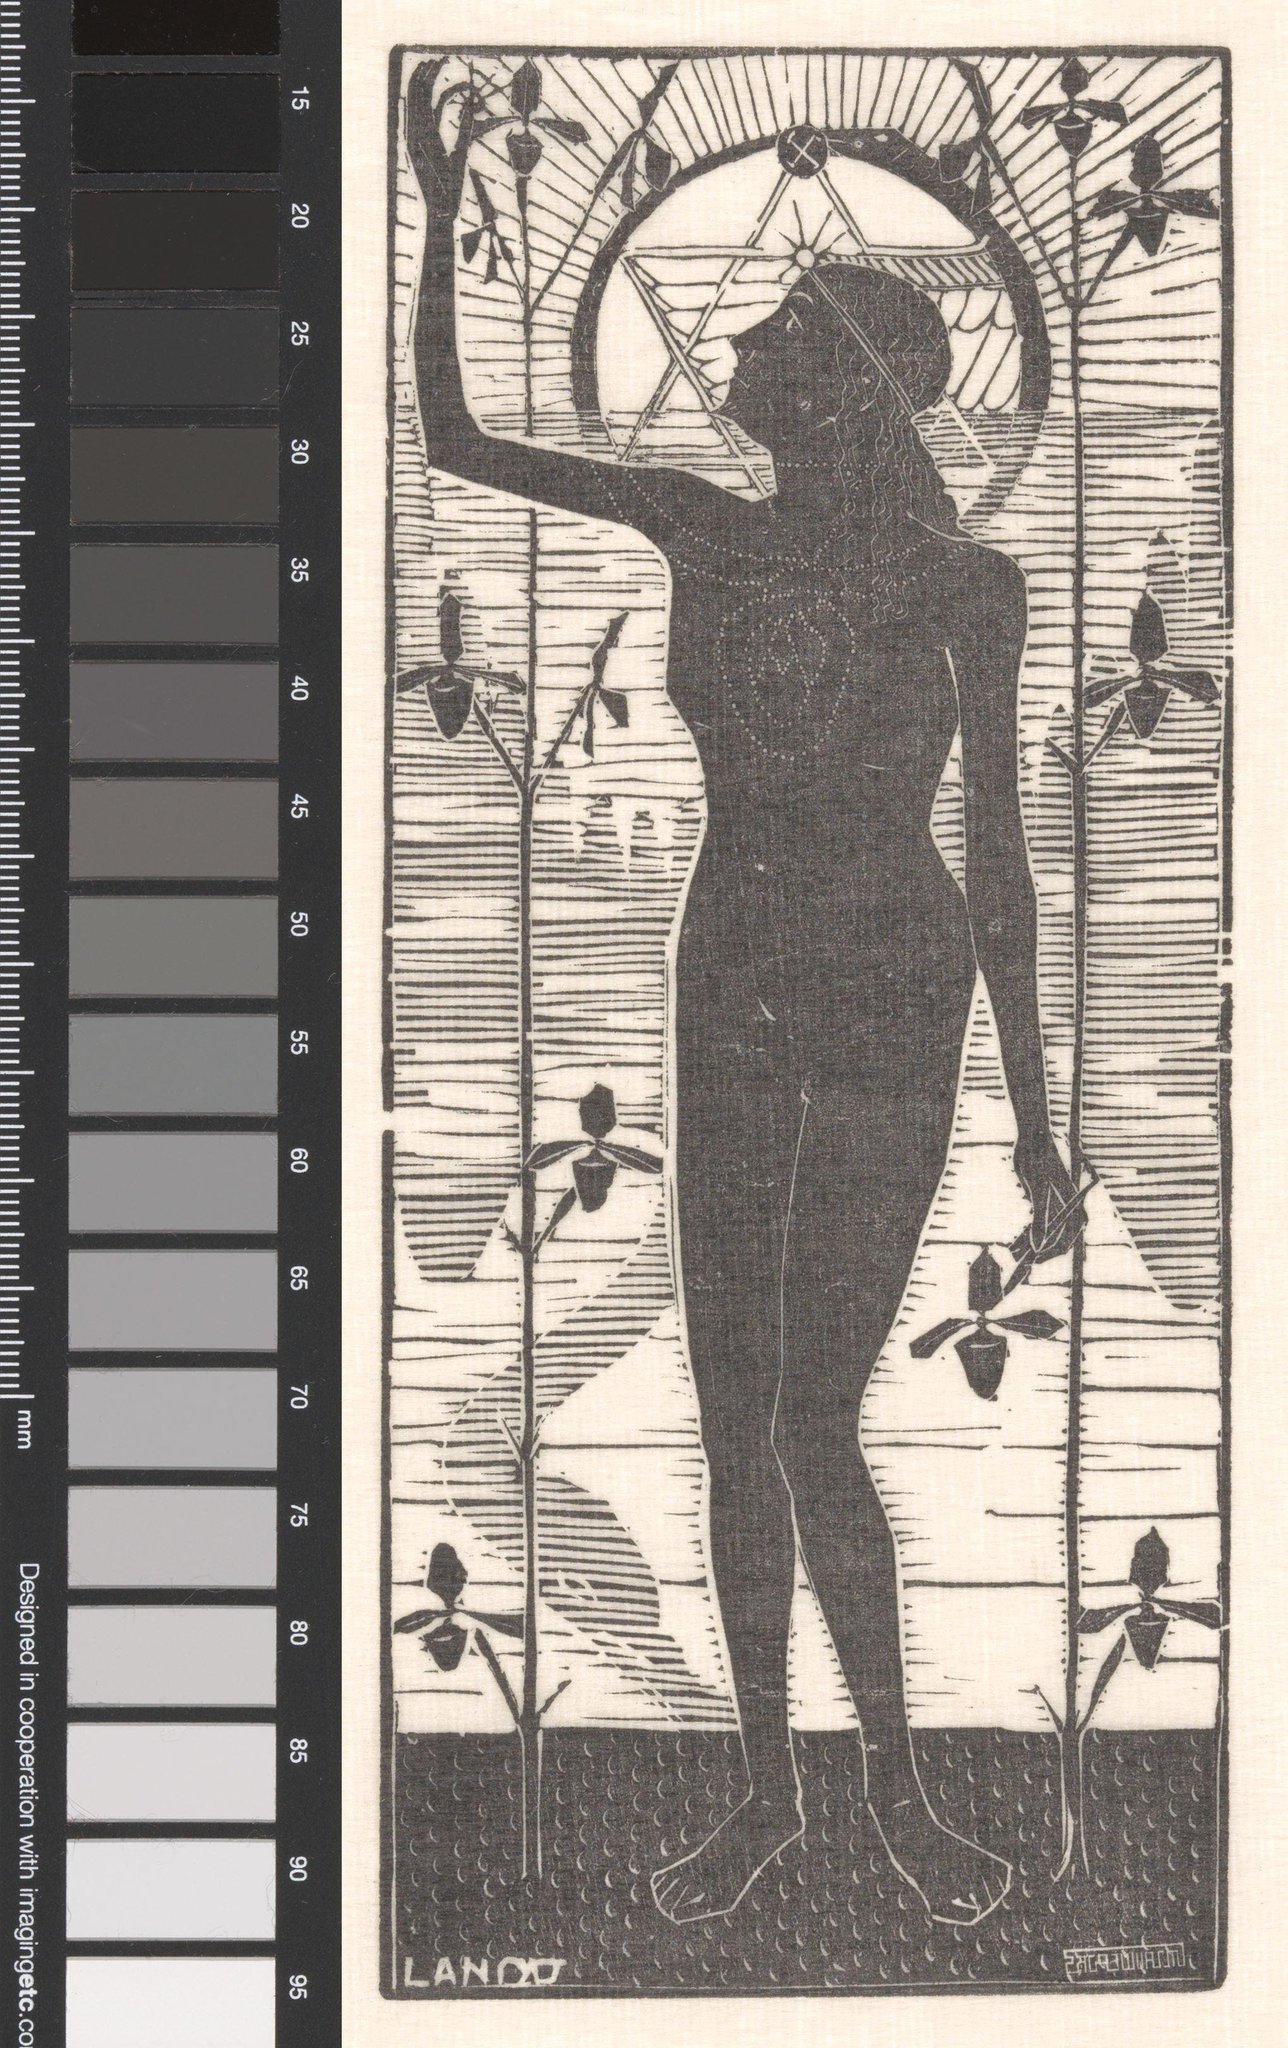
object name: illustration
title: Streven naar het hogere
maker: mathieu lauweriks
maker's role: designer, draughtsman, print maker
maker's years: 1864-1932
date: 1894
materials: paper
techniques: woodcut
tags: star forms ~ magic mathematical figures, specific forms of the cross: swastika, woman (showing herself) undressed, quasi-nude, serpent ouroboros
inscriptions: collector's mark: Lugt 2228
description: Een naakte vrouw met een puntige sik staat tussen twee plantenstengels in. Op haar borst is haar hart te zien, dat is verbonden met een ouroboros, een slang die in zijn eigen staart bijt. Bovenaan een swastika en een zespuntige ster.